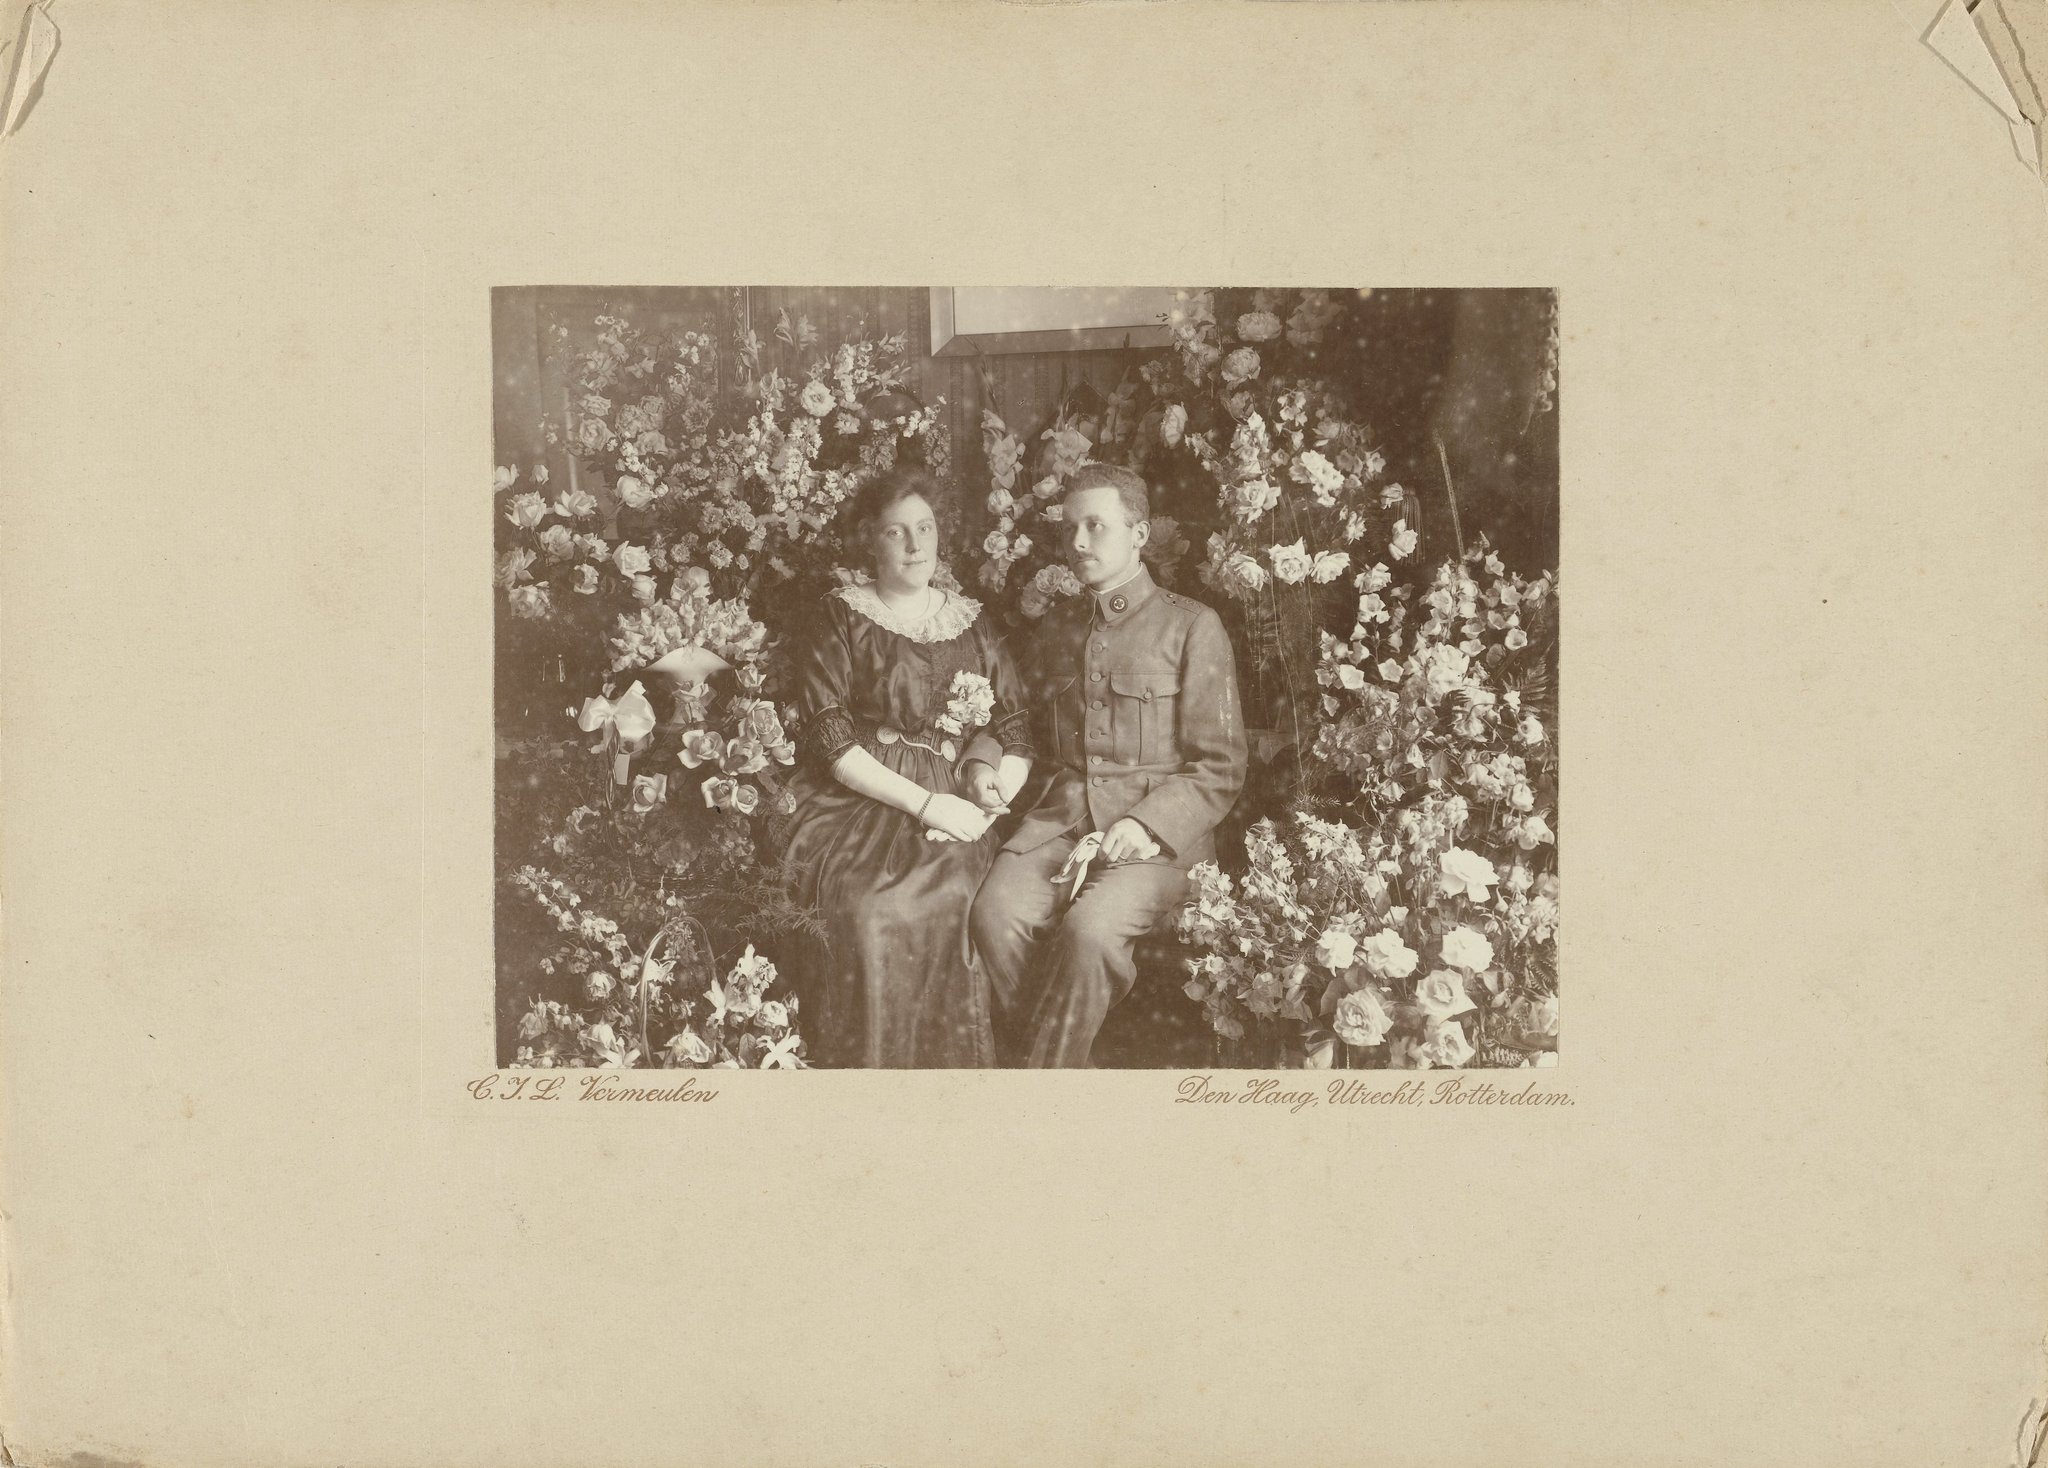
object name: photograph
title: Portret van Tine Vermeulen en Klaas Kleiterp tussen bloemen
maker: cornelis johannes lodewicus vermeulen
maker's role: fotograaf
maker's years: 1861-1936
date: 1918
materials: cardboard, photographic support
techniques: albumen print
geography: the hague